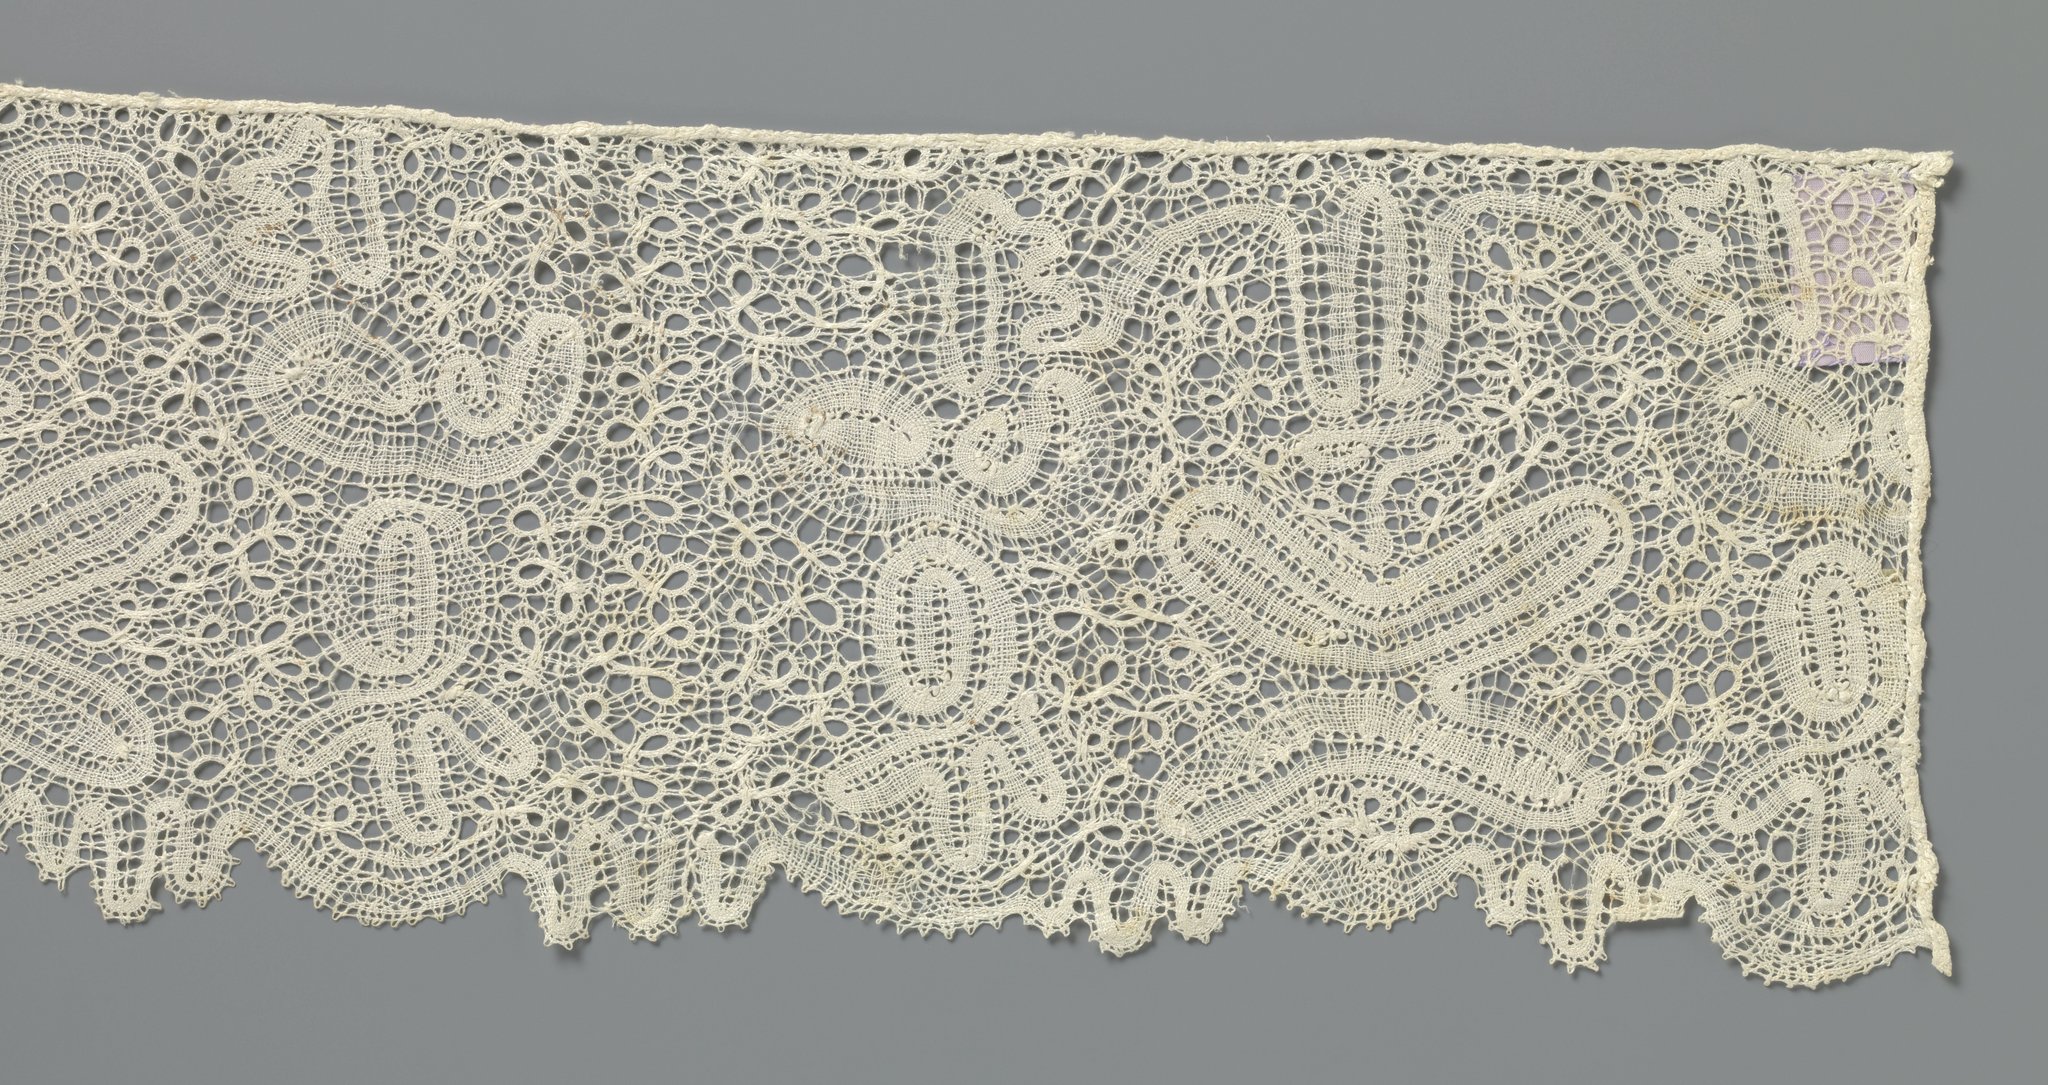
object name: strip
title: Strook kloskant met symmetrische compositie met vlindervormig motief in centrum en omring door occhiolini-lussen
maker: Anonymous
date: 1880-1899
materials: linen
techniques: lace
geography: eastern europe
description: Strook naturelkleurige kloskant, Oosteuropese kant. Het zich herhalende patroon bestaat uit een min of meer symmetrische compositie waarbij de contouren van de motieven zijn gemaakt met kronkelende linten, die minimaal in breedte variëren. De compositie bestaat in het centrum uit een vlindervormig motief met een soort baldakijn erboven waaraan aan beide zijden dezelfde omkrullende motieven naar beneden hangen. De motieven zijn met elkaar verbonden door een lussenpatroon zoals bij occhiolini. De linten zijn deels gemaakt in netslag en grotendeels in linnenslag met opengewerkte randjes. De bovenzijde van de strook is recht afgewerkt. Een doorgaand en kronkelend lint zorgt voor een schulpenrand langs de onderzijde van de strook.